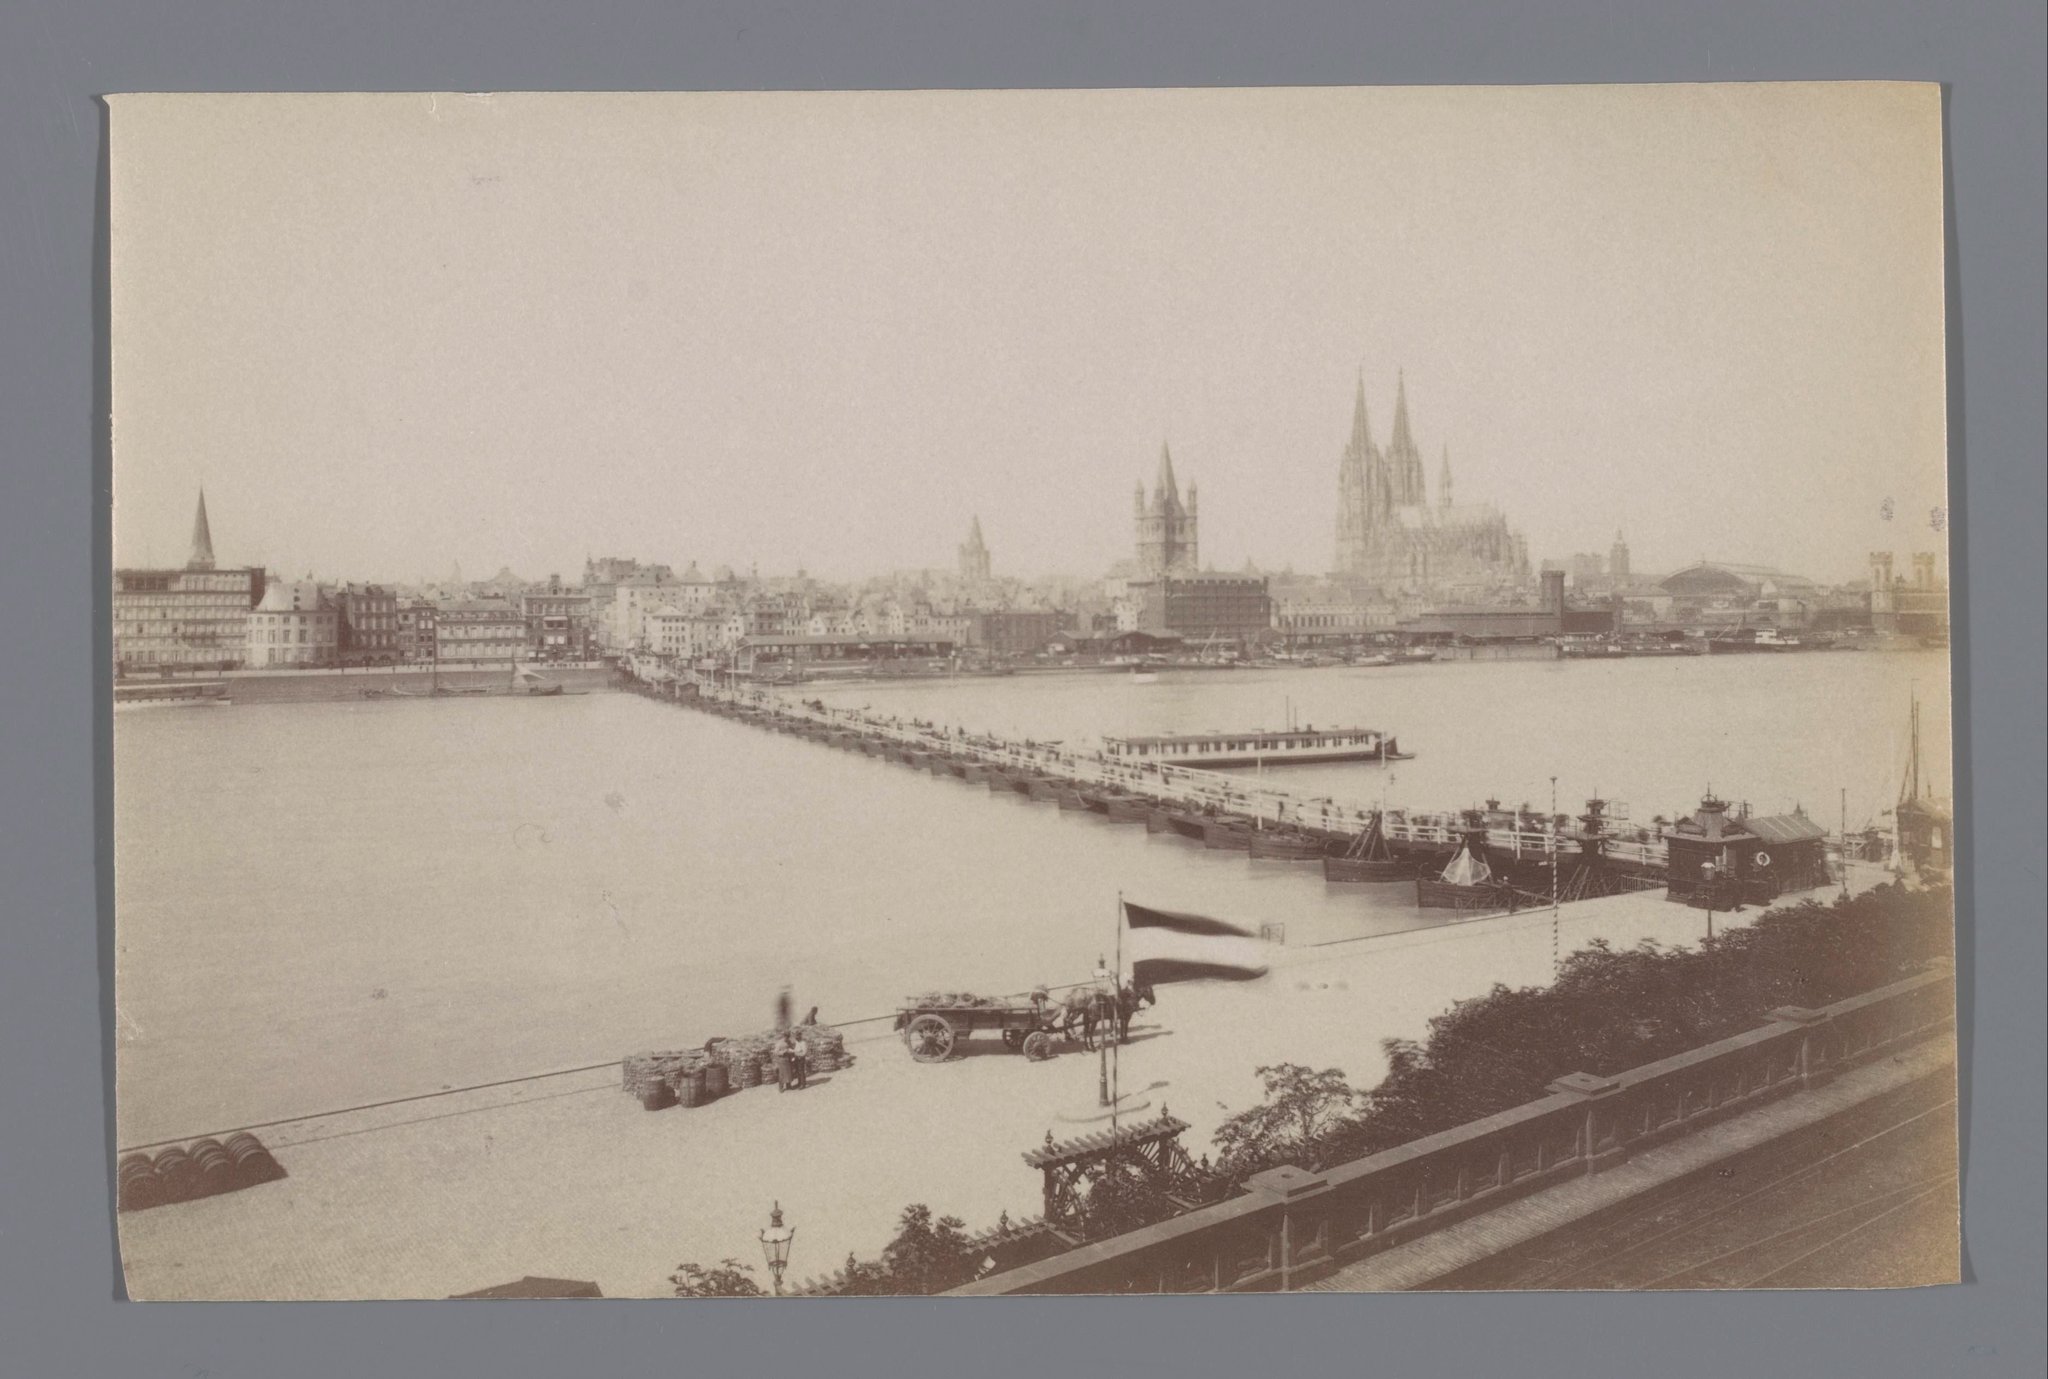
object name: photograph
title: Gezicht op Keulen en de Rijn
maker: Anonymous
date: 1880-1910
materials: paper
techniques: albumen print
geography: deutz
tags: city-view in general; 'veduta', river, pontoon bridge, cologne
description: De foto is gemaakt vanaf de rechter oever van de Rijn, vanuit Deutz, met zicht op de pontonbrug tussen Keulen en Deutz.